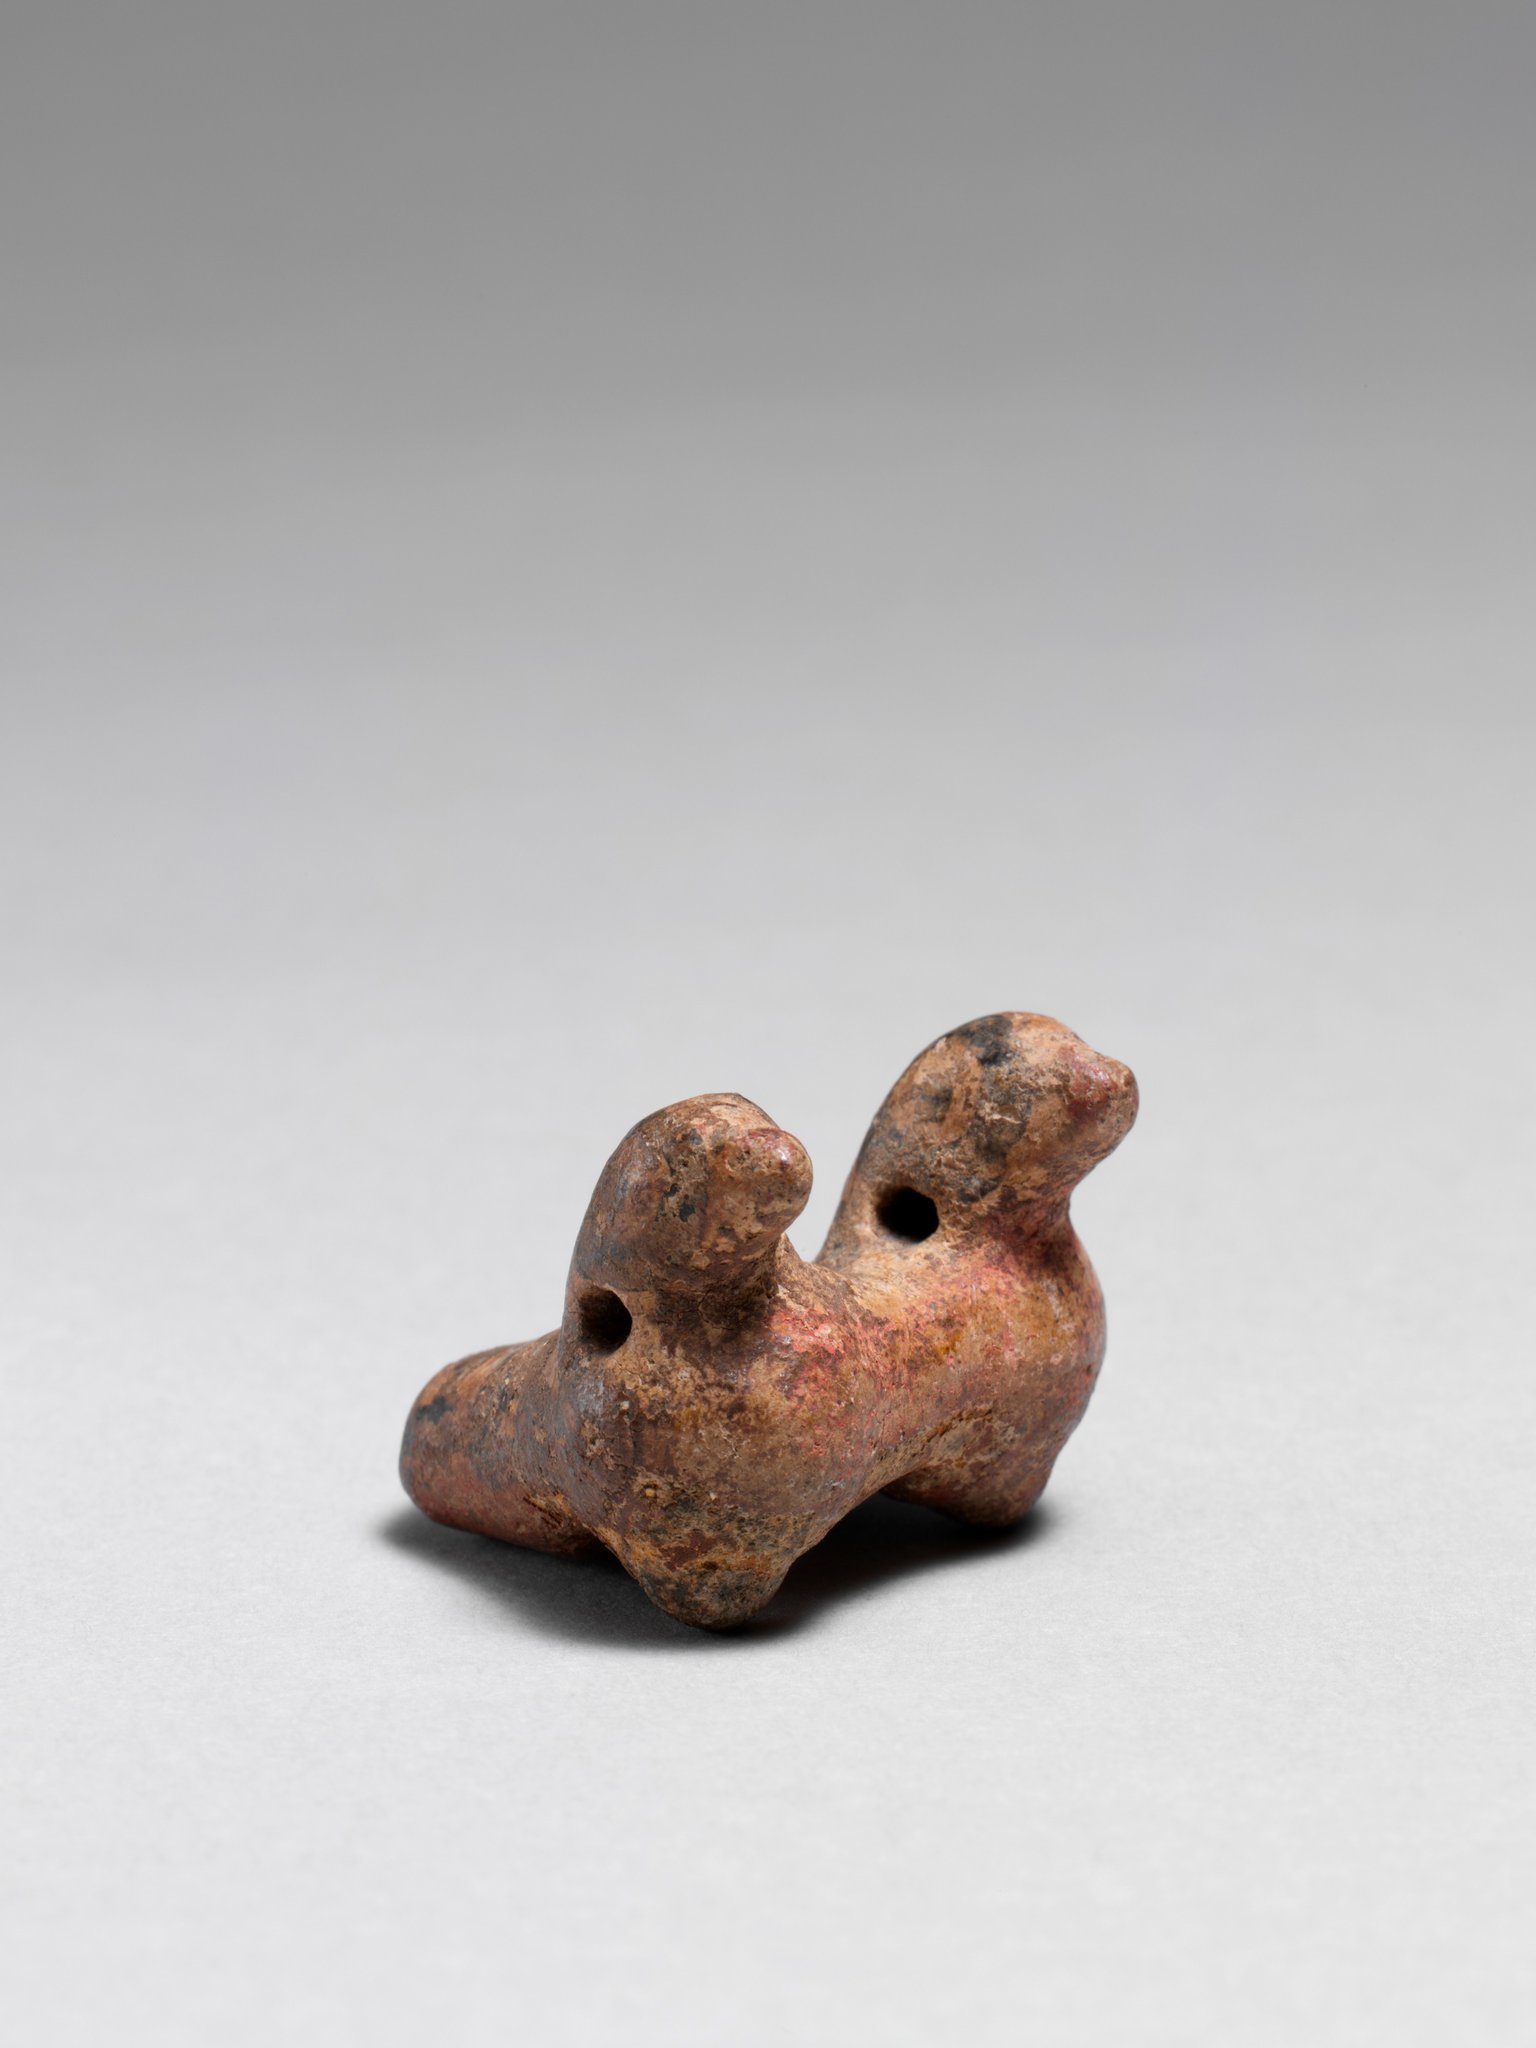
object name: pottery whistle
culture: costa rican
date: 800-1525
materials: clay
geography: costa rica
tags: birds